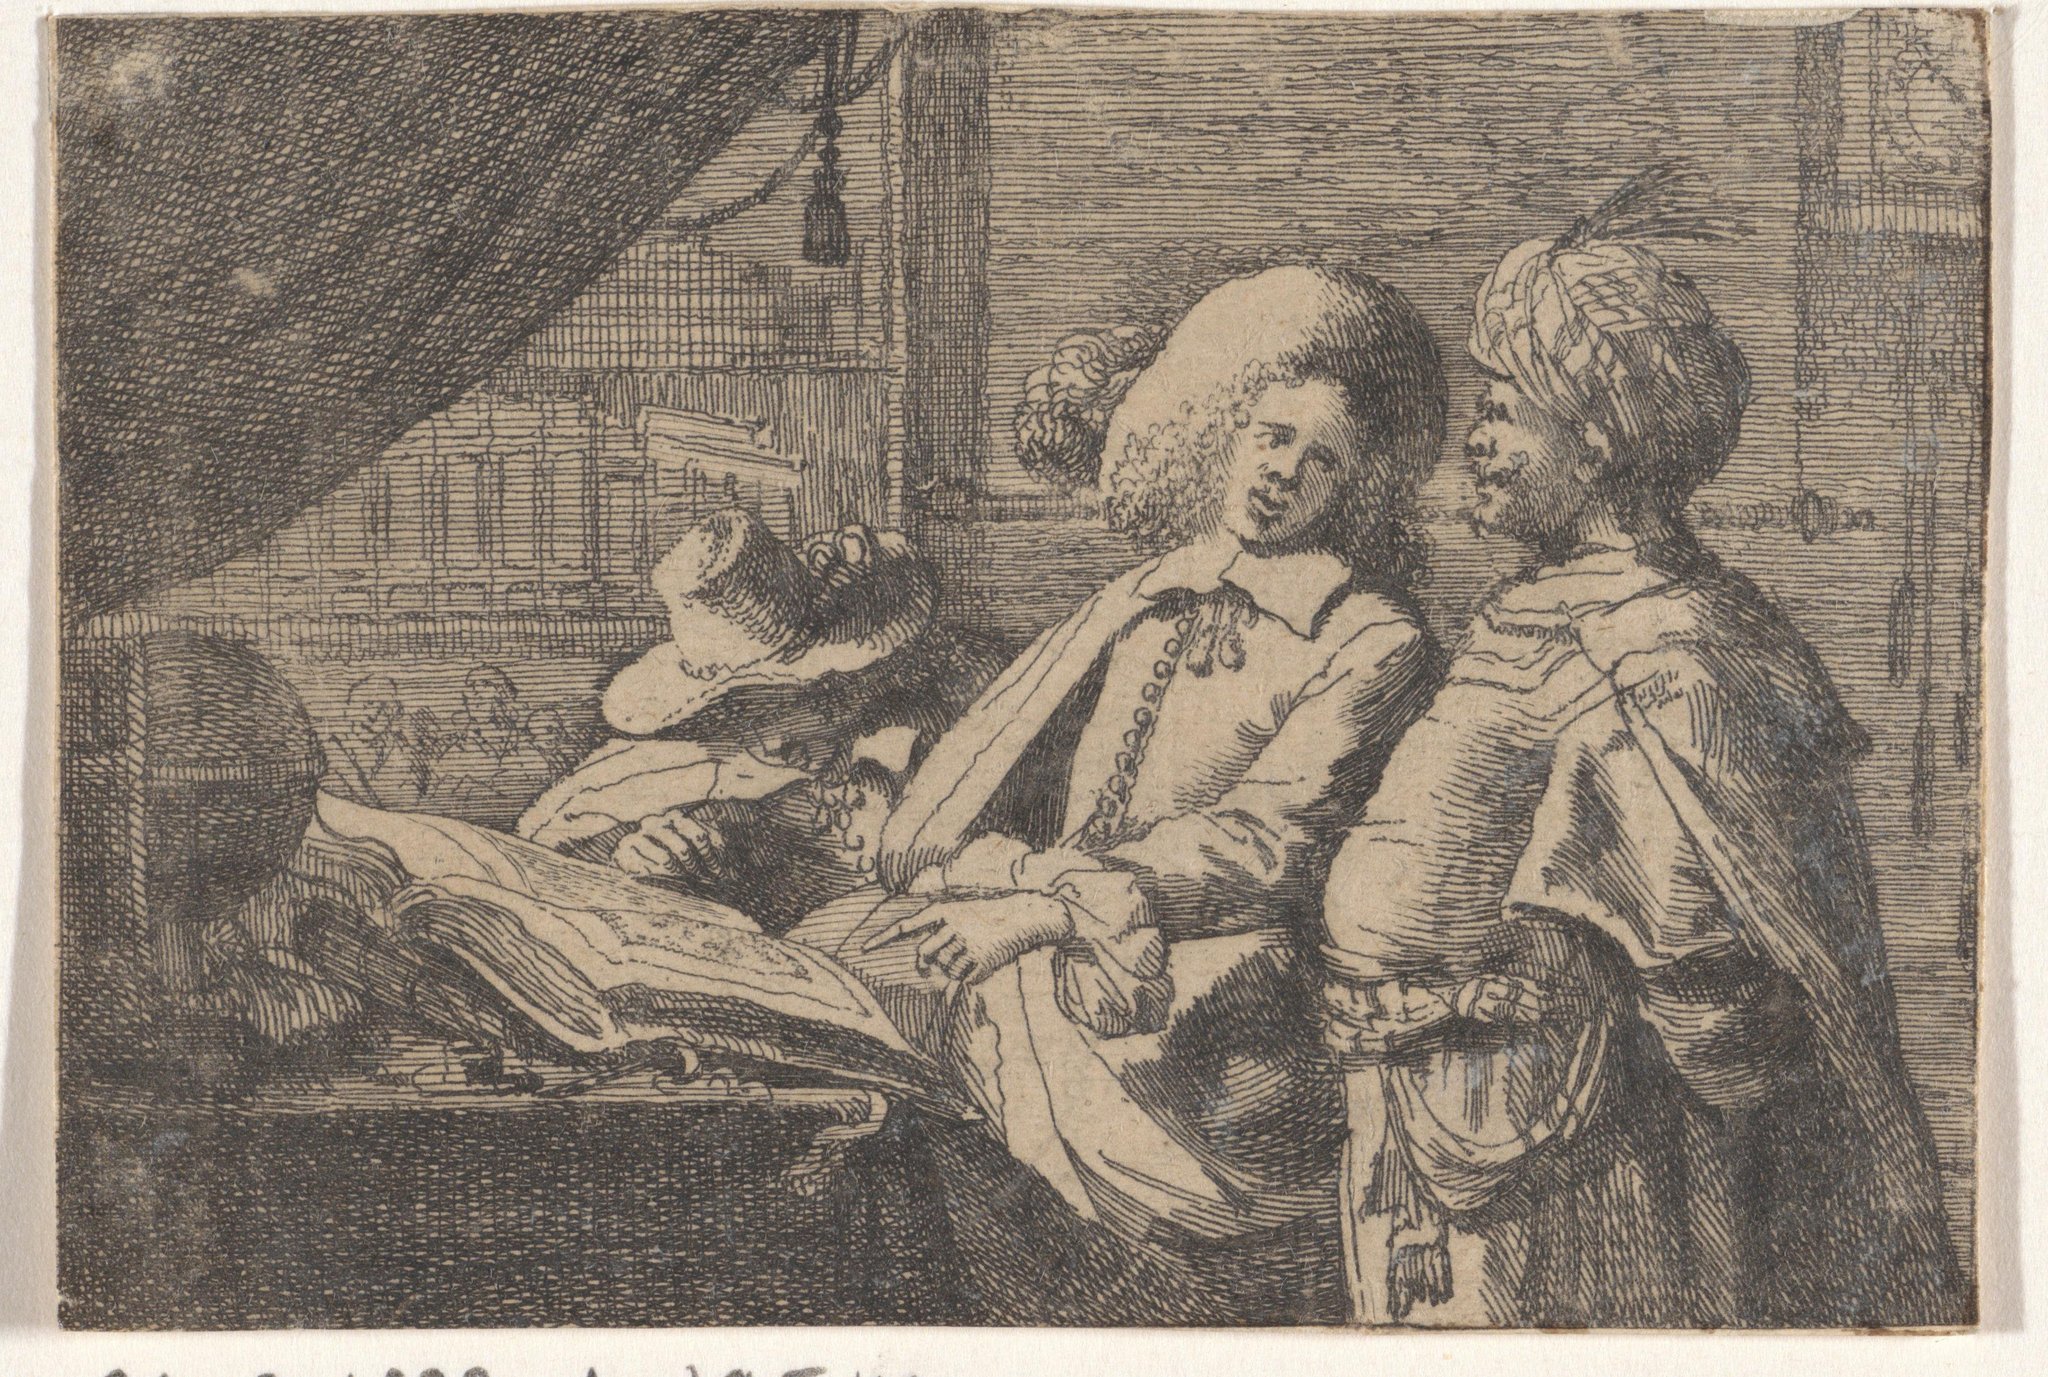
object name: print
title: Drie mannen rond een boek in een kantoor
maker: Anonymous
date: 1600-1700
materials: paper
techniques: etching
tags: head-gear: turban, book, office (~ administration)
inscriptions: collector's mark: Lugt 2228